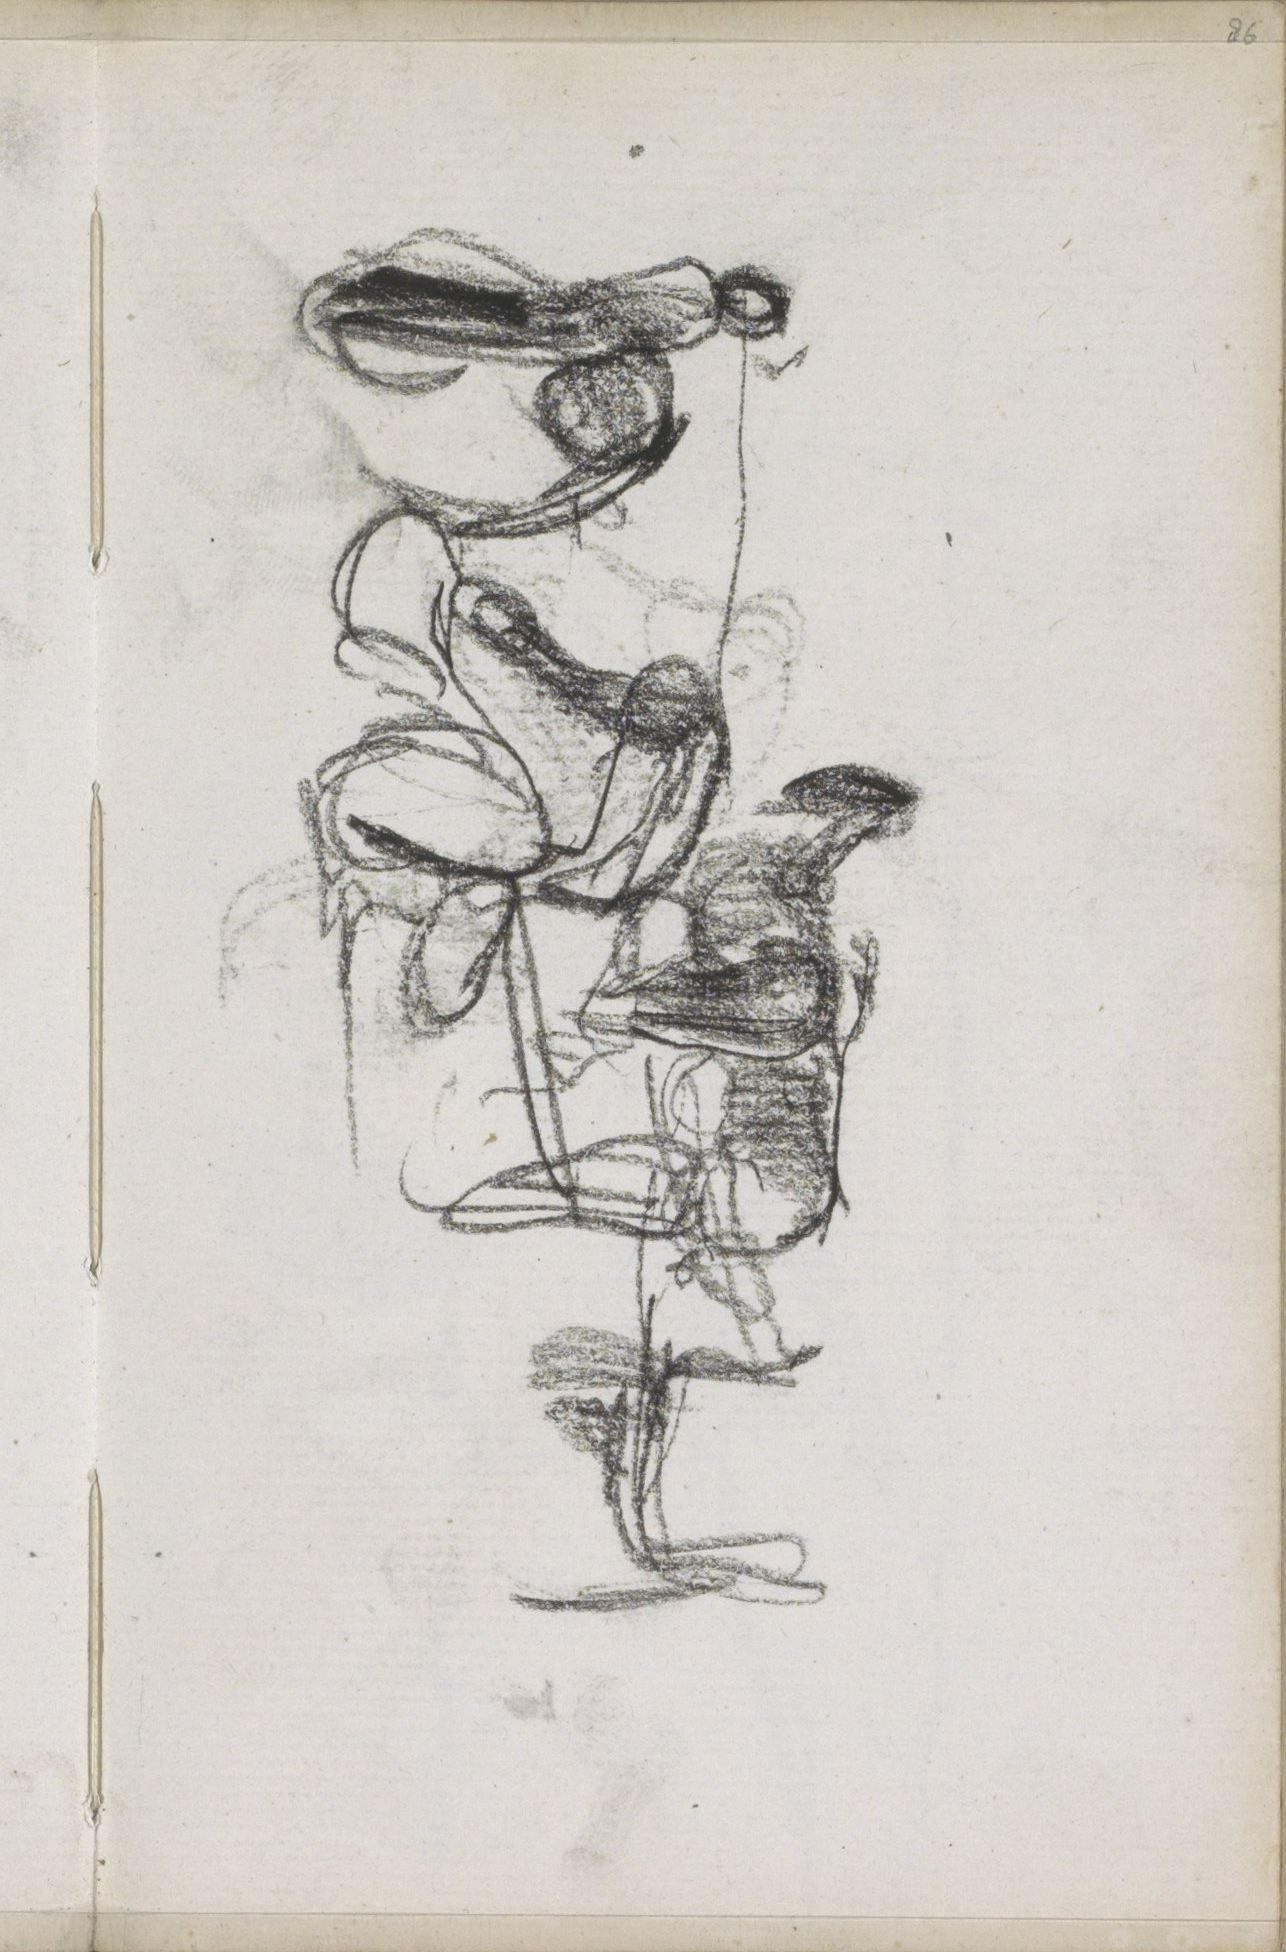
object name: sketchbook leaf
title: Figuur voor een paard-en-wagen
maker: george hendrik breitner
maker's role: draughtsman, painter, print maker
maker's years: 1857-1923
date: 1884-1886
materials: chalk, paper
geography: drenthe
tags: four-wheeled, animal-drawn vehicle, e.g.: cab, carriage, coach, horse, (farm) wagon, freight wagon, cart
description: Pagina 86 uit een schetsboek met 67 bladen vervaardigd in Drenthe.